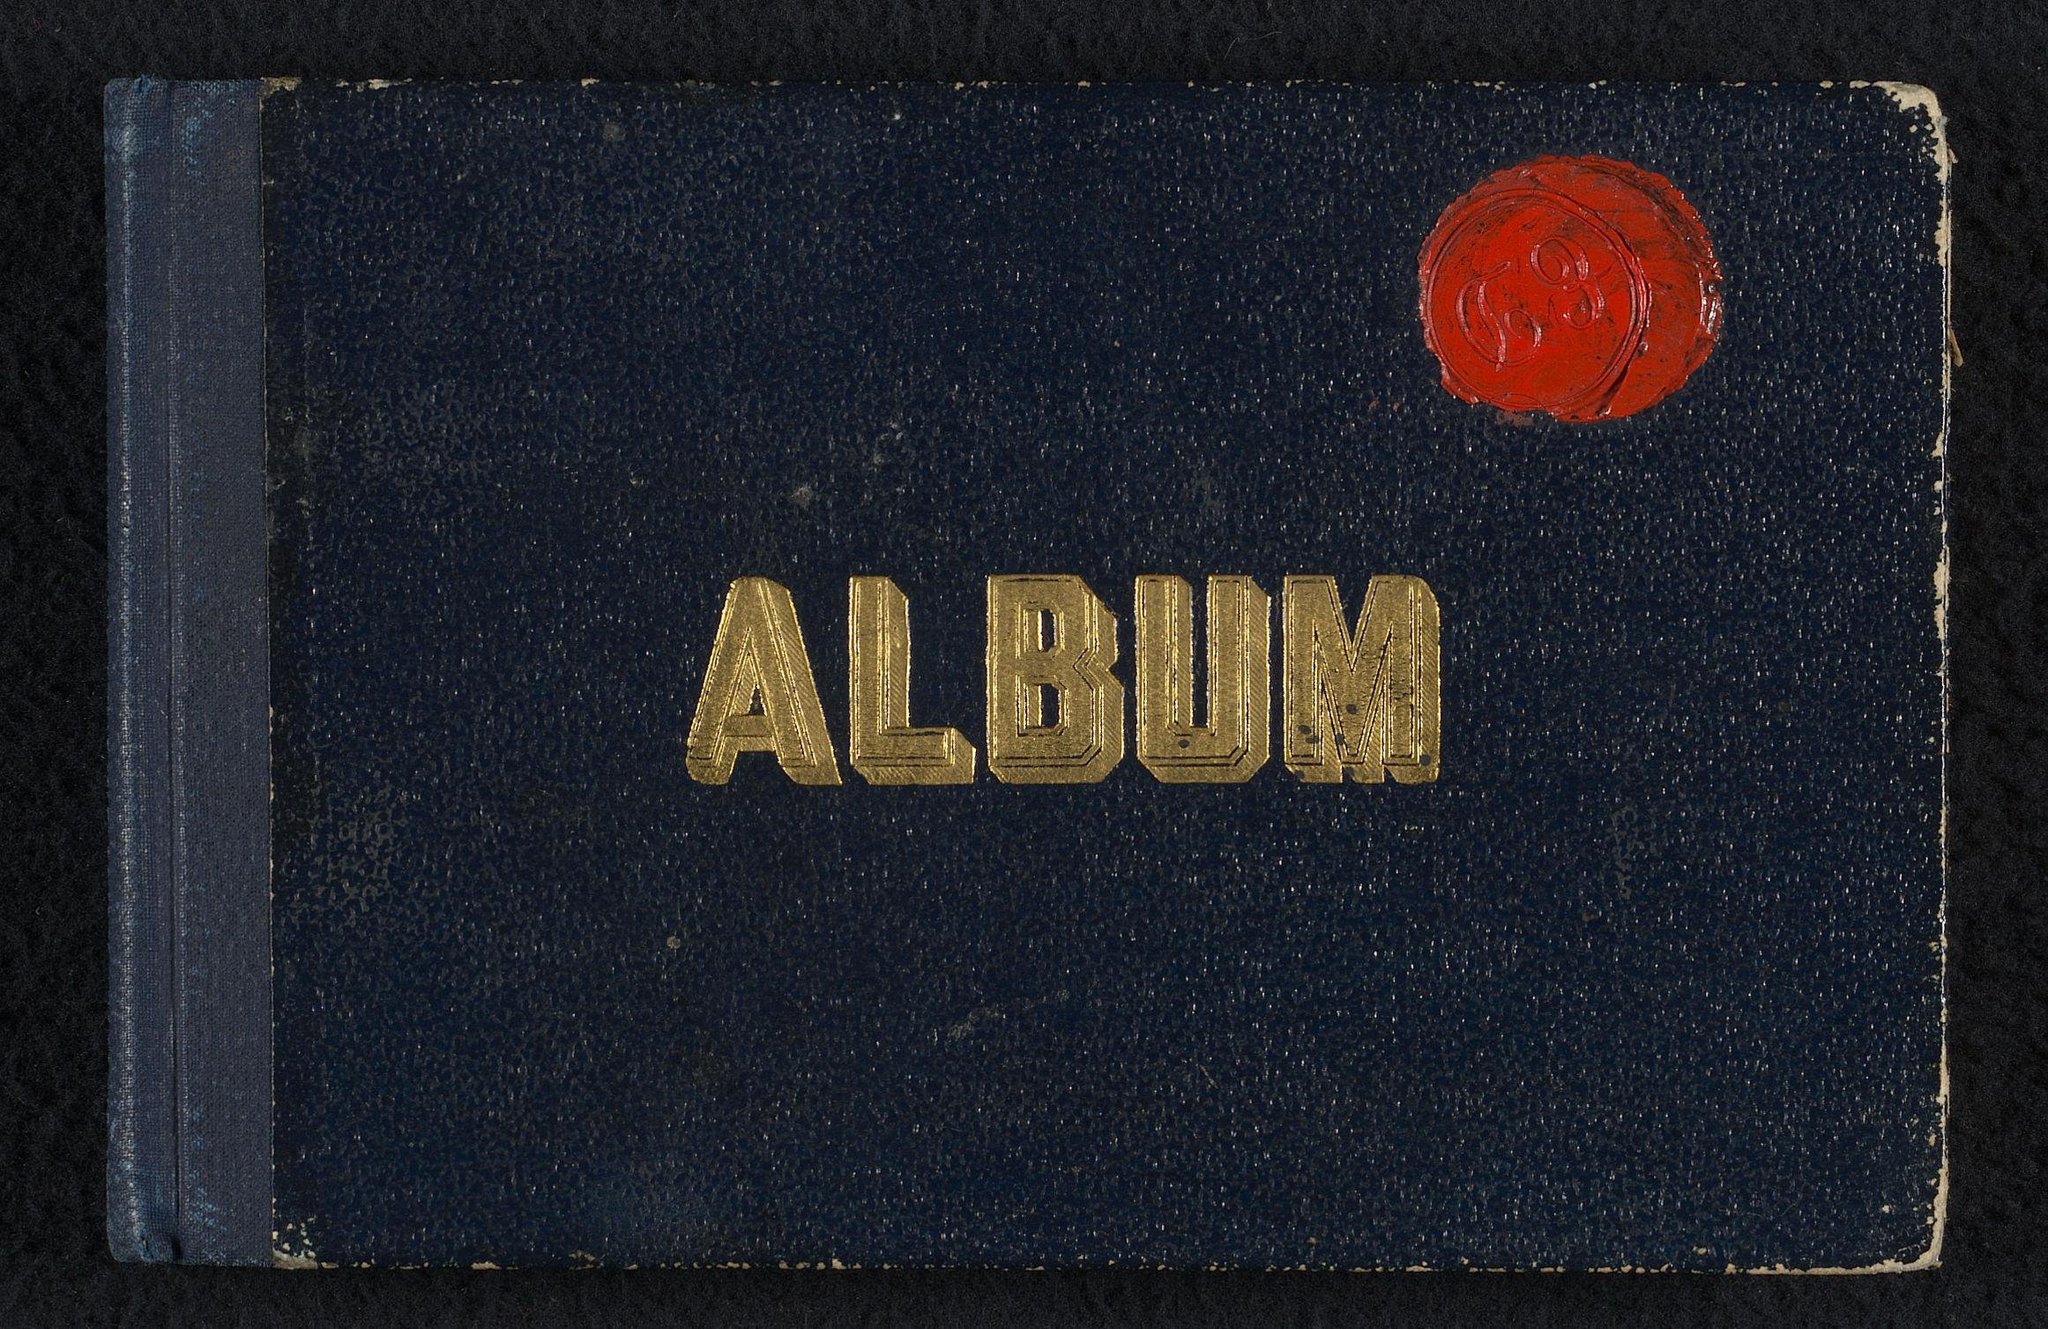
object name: sketchbook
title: Schetsboek met 46 bladen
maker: eugène delacroix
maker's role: draughtsman, print maker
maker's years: 1798-1863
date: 1852-1854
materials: cardboard, linen, paper, pencil, wax, watercolor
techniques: brush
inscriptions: inscription: ‘Demander au café de l'Esperance, quai Duquesne 6’, seal: ‘ED’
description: De volgende bladen uit het schetsboek zijn blanco: 5(V), 9(V), 11(V), 13 (V),15 (V), 17(V), 19(V), 29(V), 33(V), 41(V), 43(V), 45(V), 65(V), 66(R), 69(V), 71 (V), 73(V), 75(V), 79(V) en 83(V) t/m 90(R).